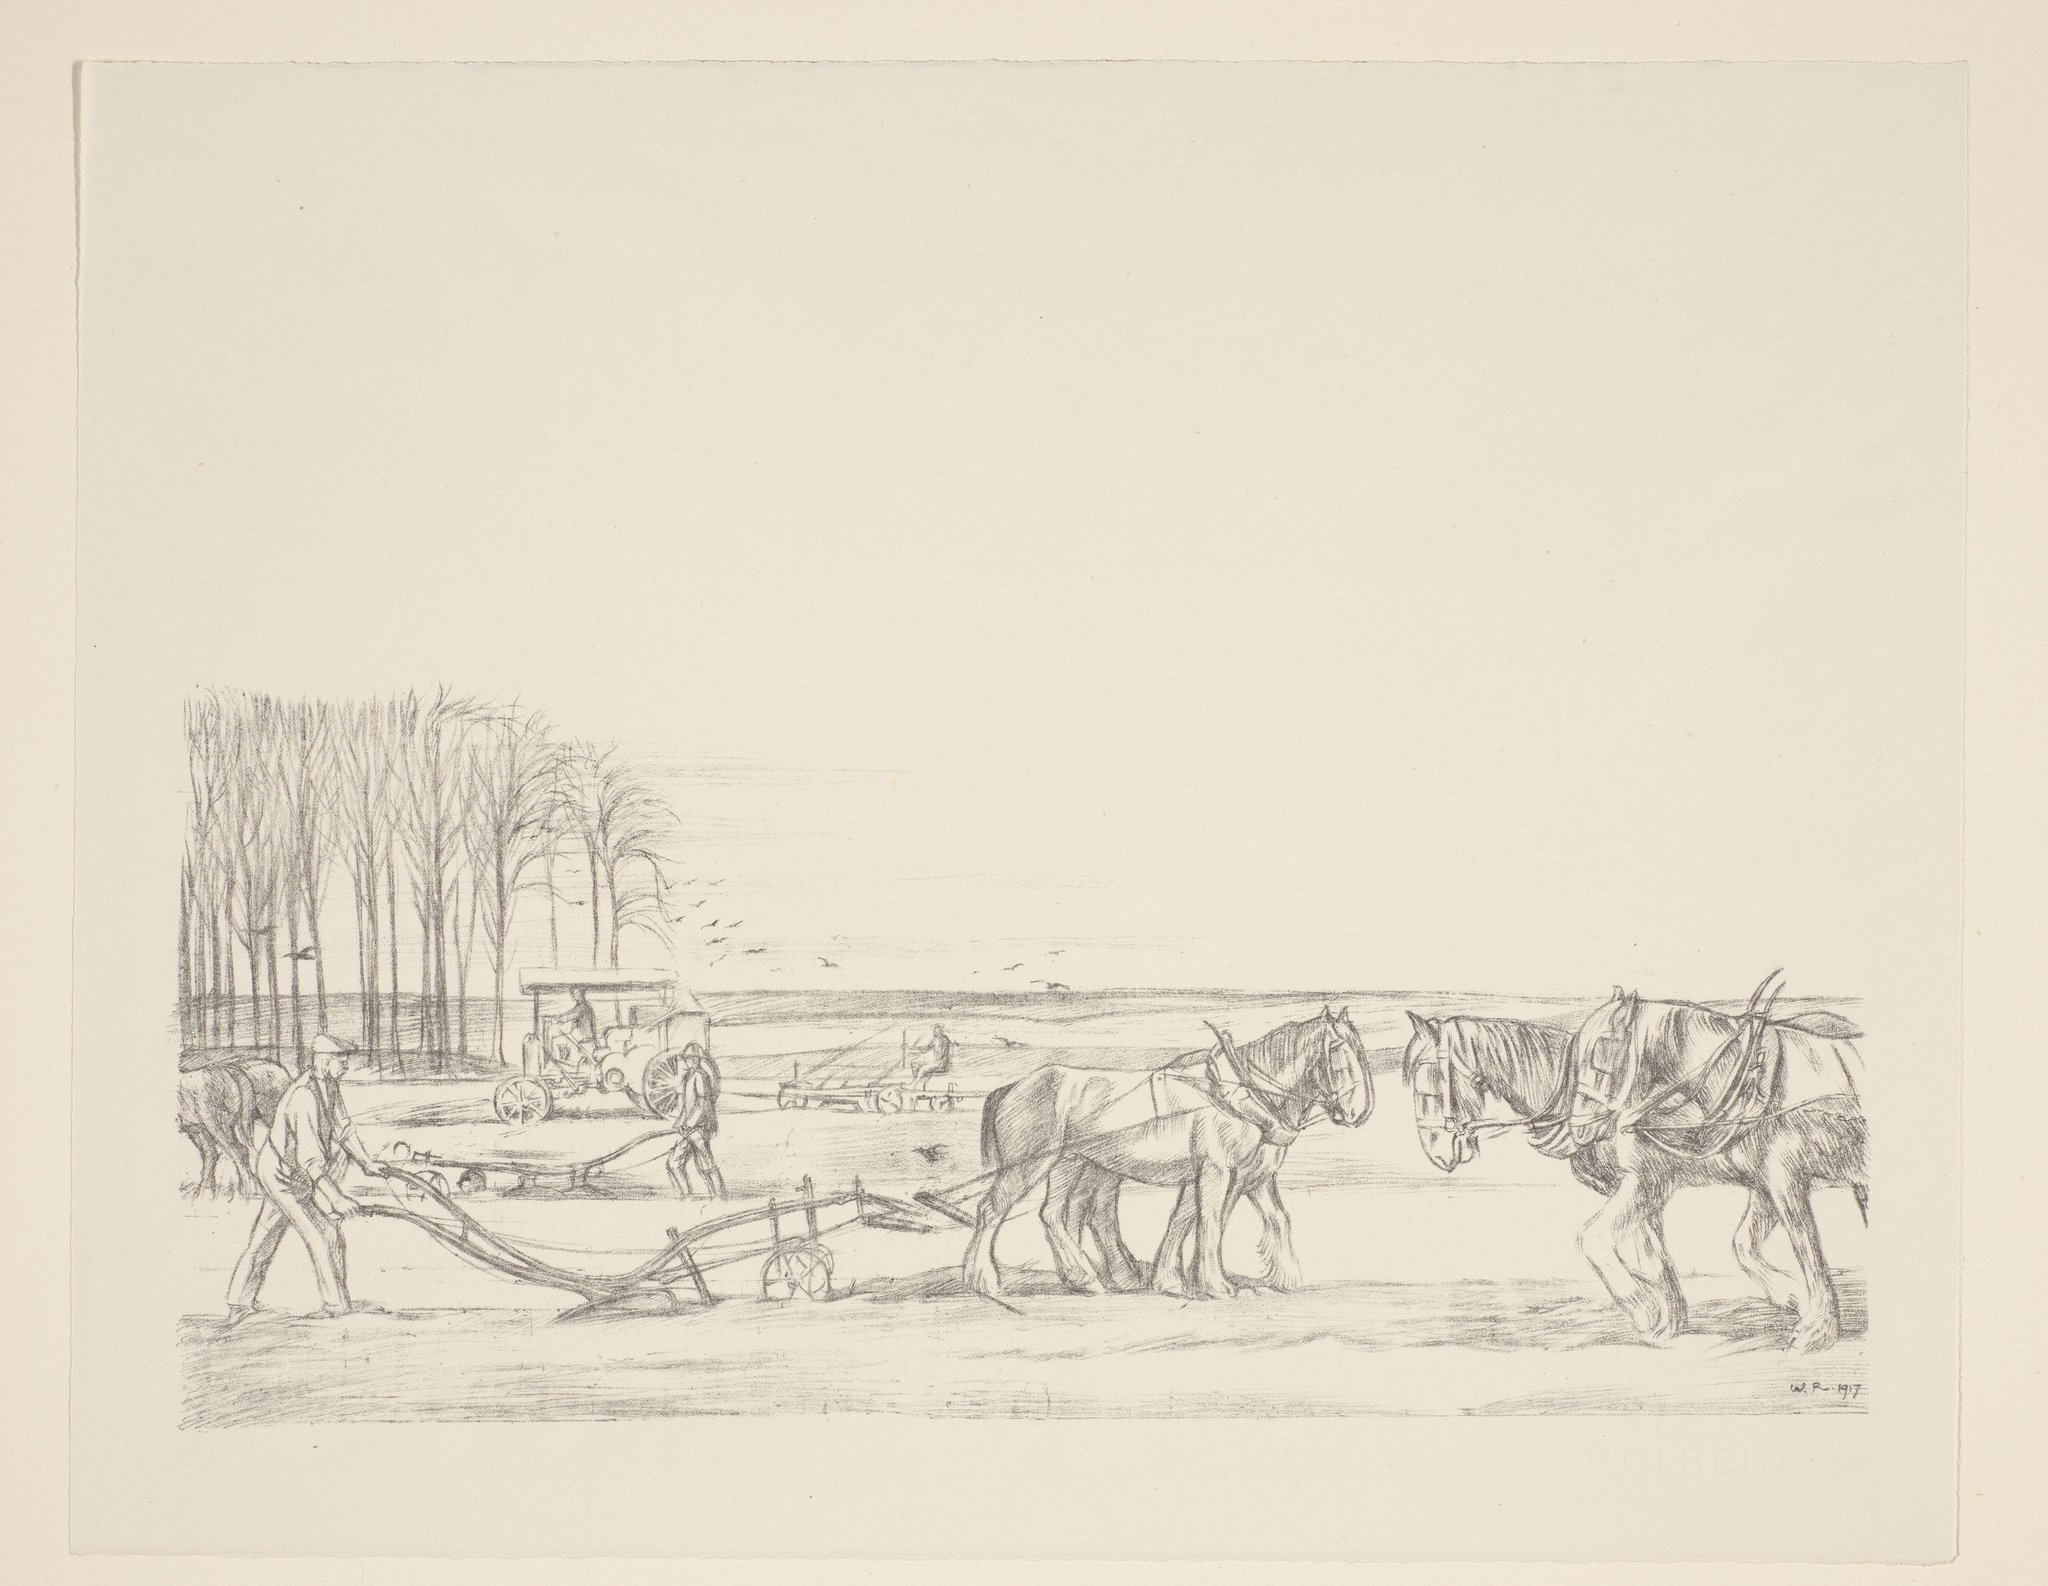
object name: print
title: Ploegen van het land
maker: william rothenstein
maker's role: print maker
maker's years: 1872-1945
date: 1917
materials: paper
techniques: lithograph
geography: england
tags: farmers - aa - female farmer, farmer's wife, potatoes, ploughing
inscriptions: watermark, watermark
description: Deze prent behoort tot de reeks 'Work on the Land' binnen de serie 'The Great War: Britain’s Efforts and Ideals'.